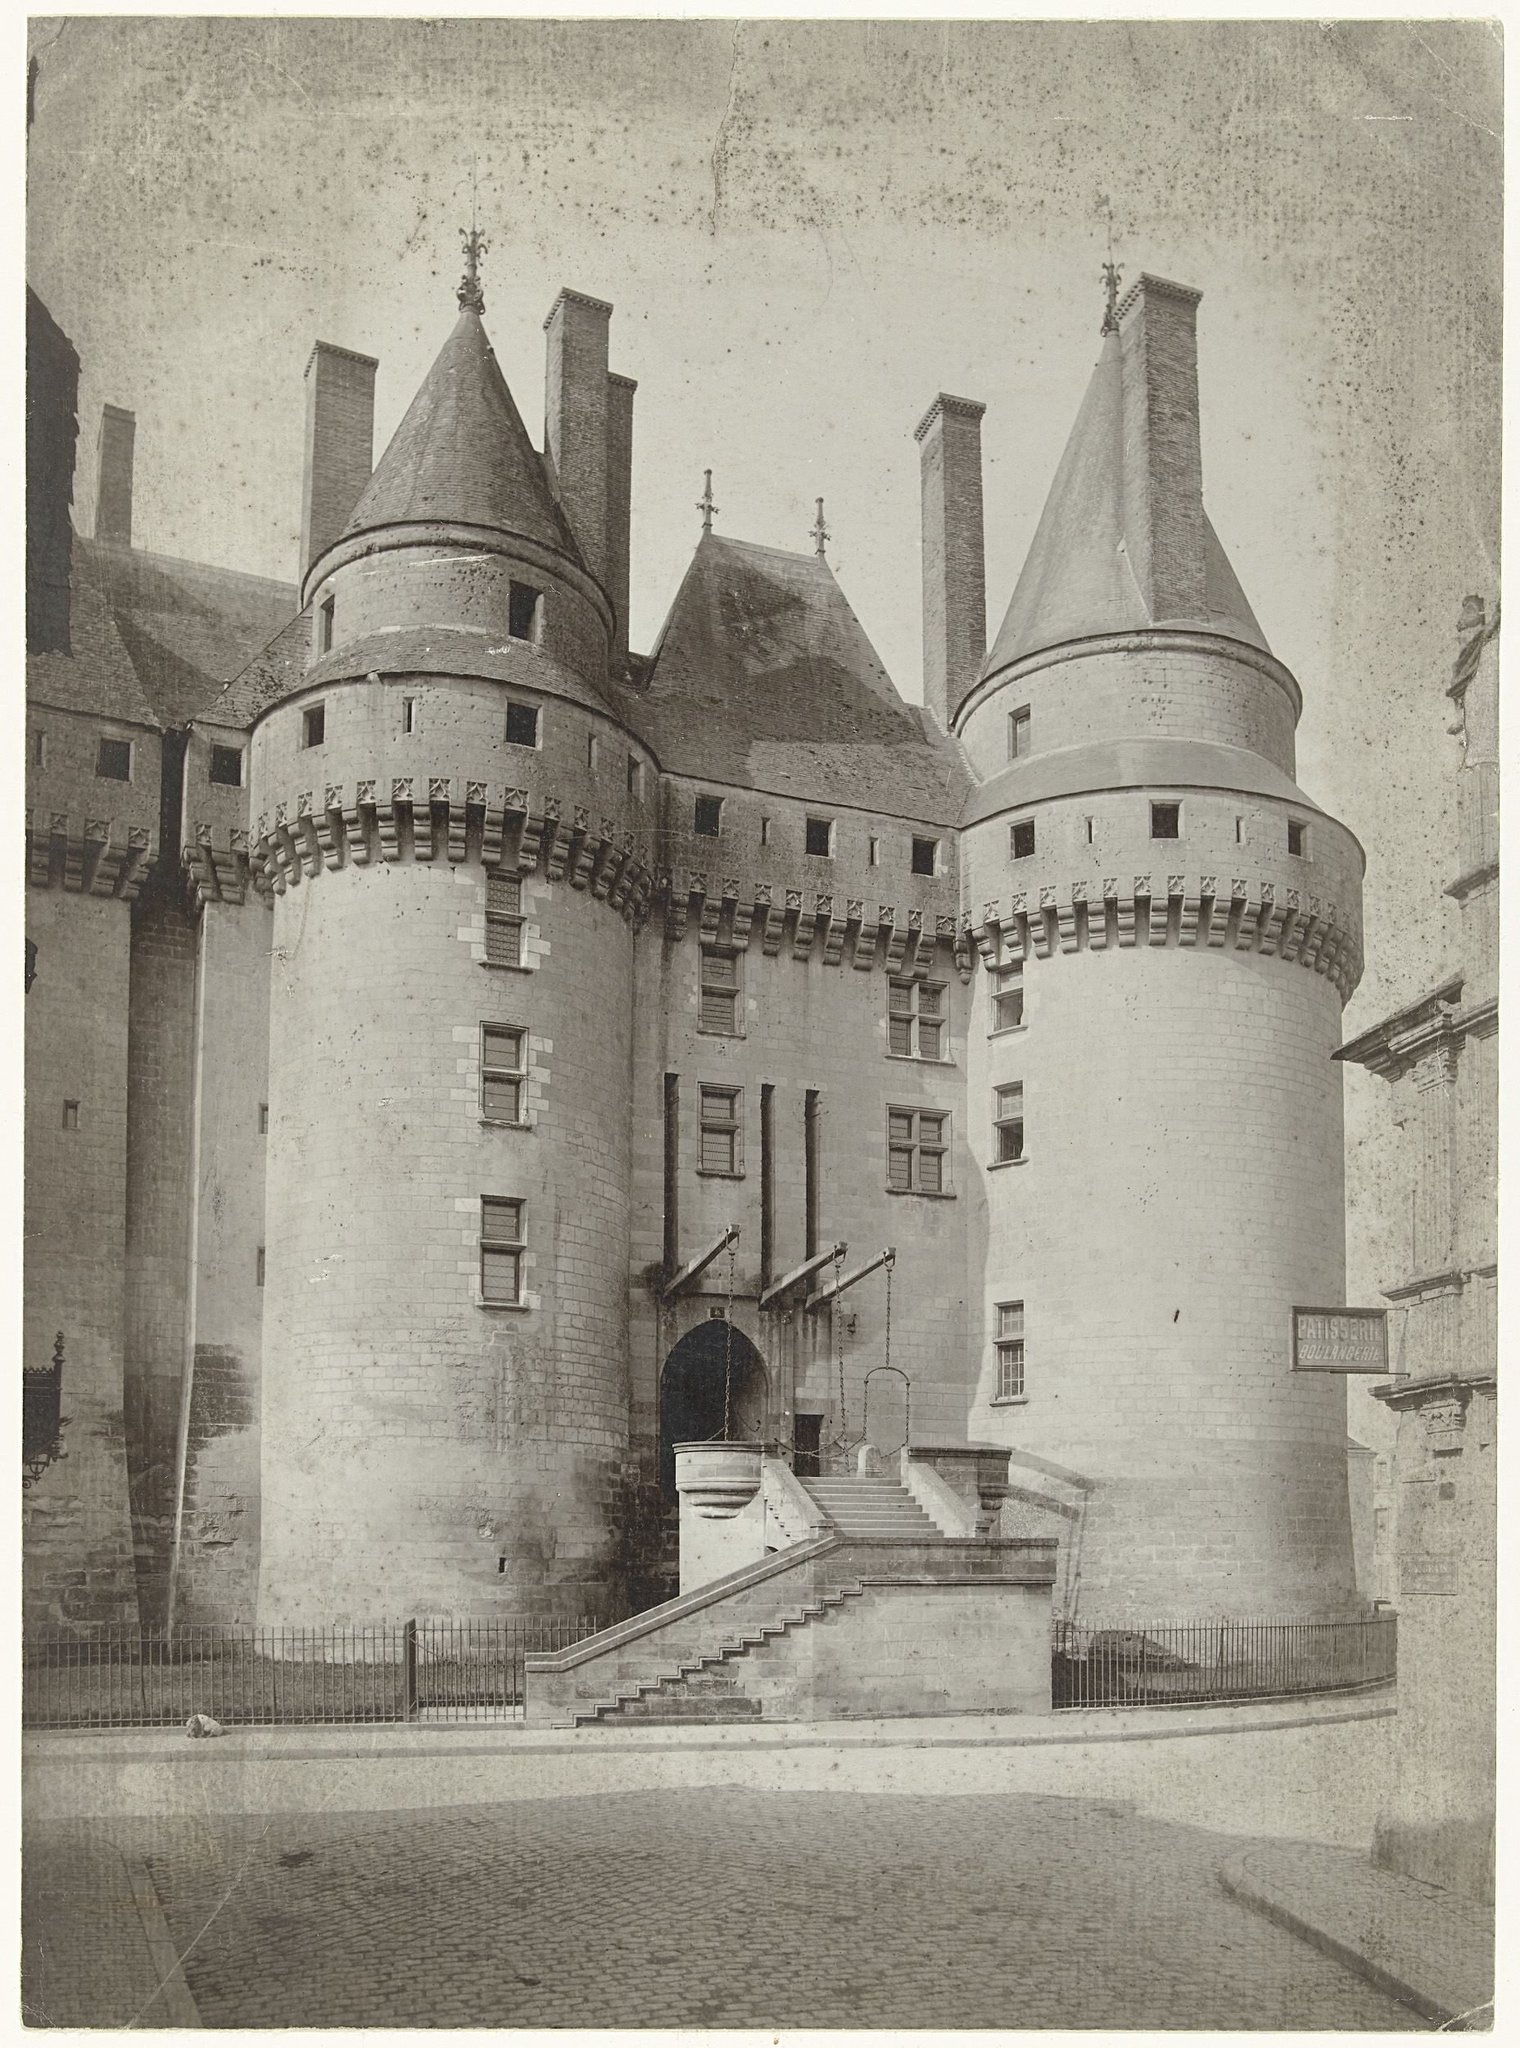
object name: photograph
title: Langeais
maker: Anonymous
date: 1900-1920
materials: paper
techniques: gelatin silver print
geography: langeais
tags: castle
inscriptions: inscription: ‘Langeais’